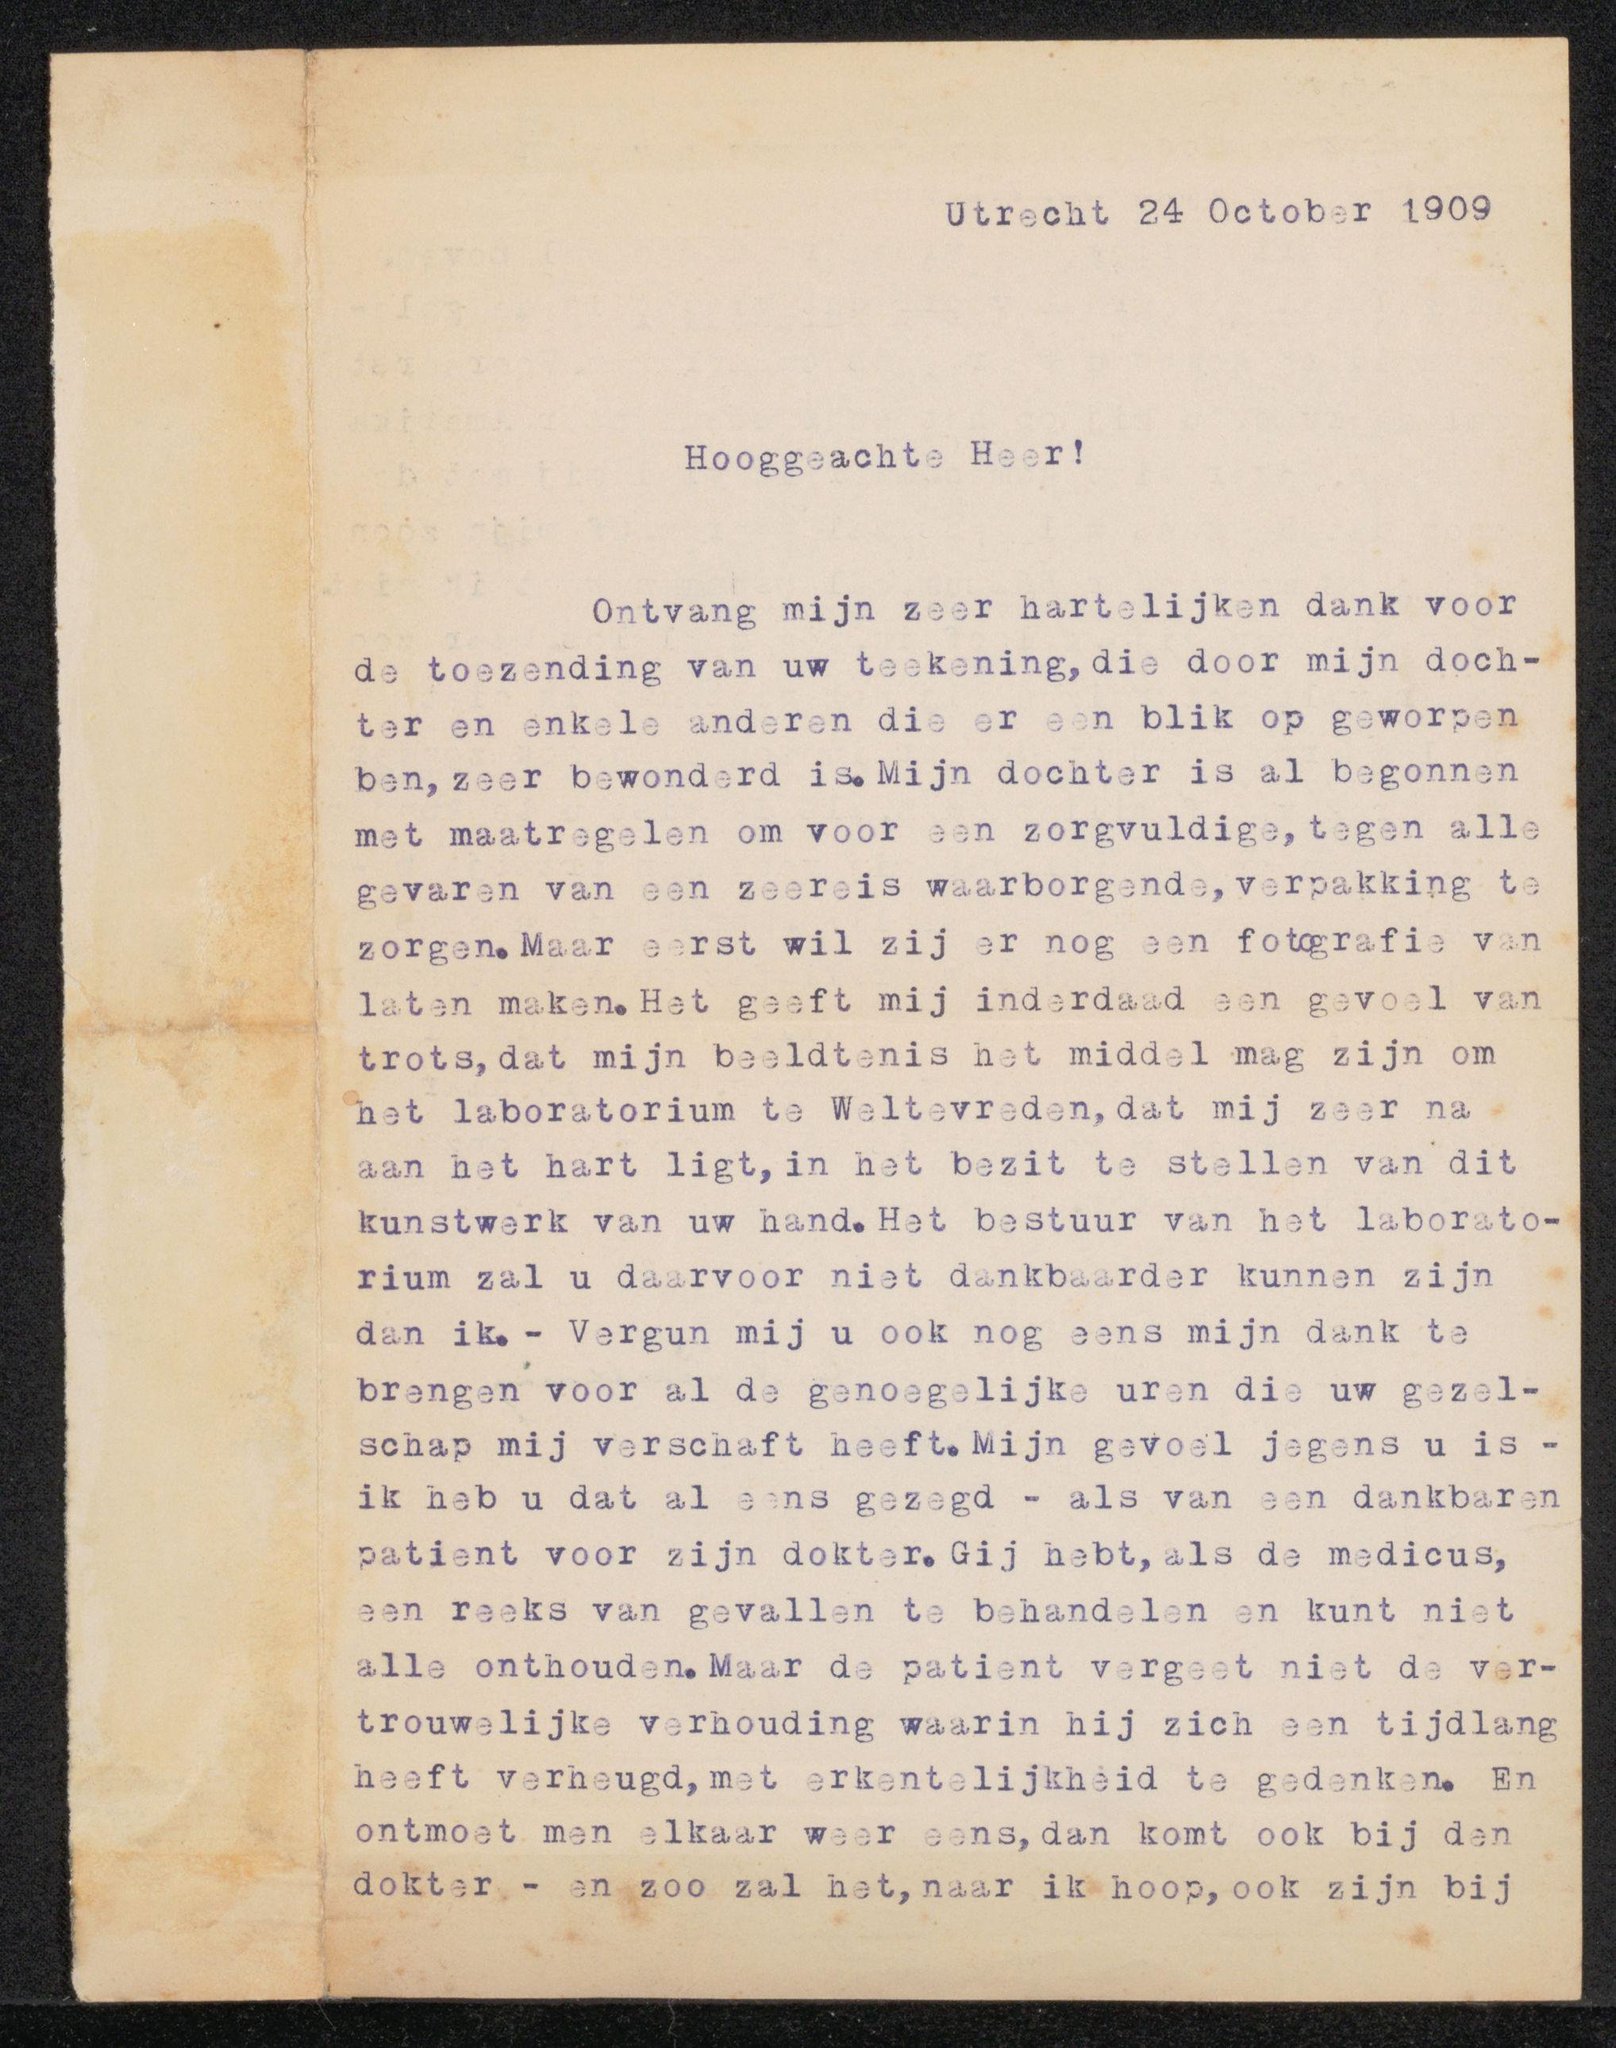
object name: letter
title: Brief aan Jan Veth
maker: cornelis adrianus pekelharing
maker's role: arts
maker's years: 1848-1922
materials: ink, paper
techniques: pen, typewriting, writing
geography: utrecht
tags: amsterdam, painter, draughtsman, designer, jan veth, drawing, photography, cinematography, historical persons (portraits and scenes from the life)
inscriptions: collector's mark: ‘RPK’